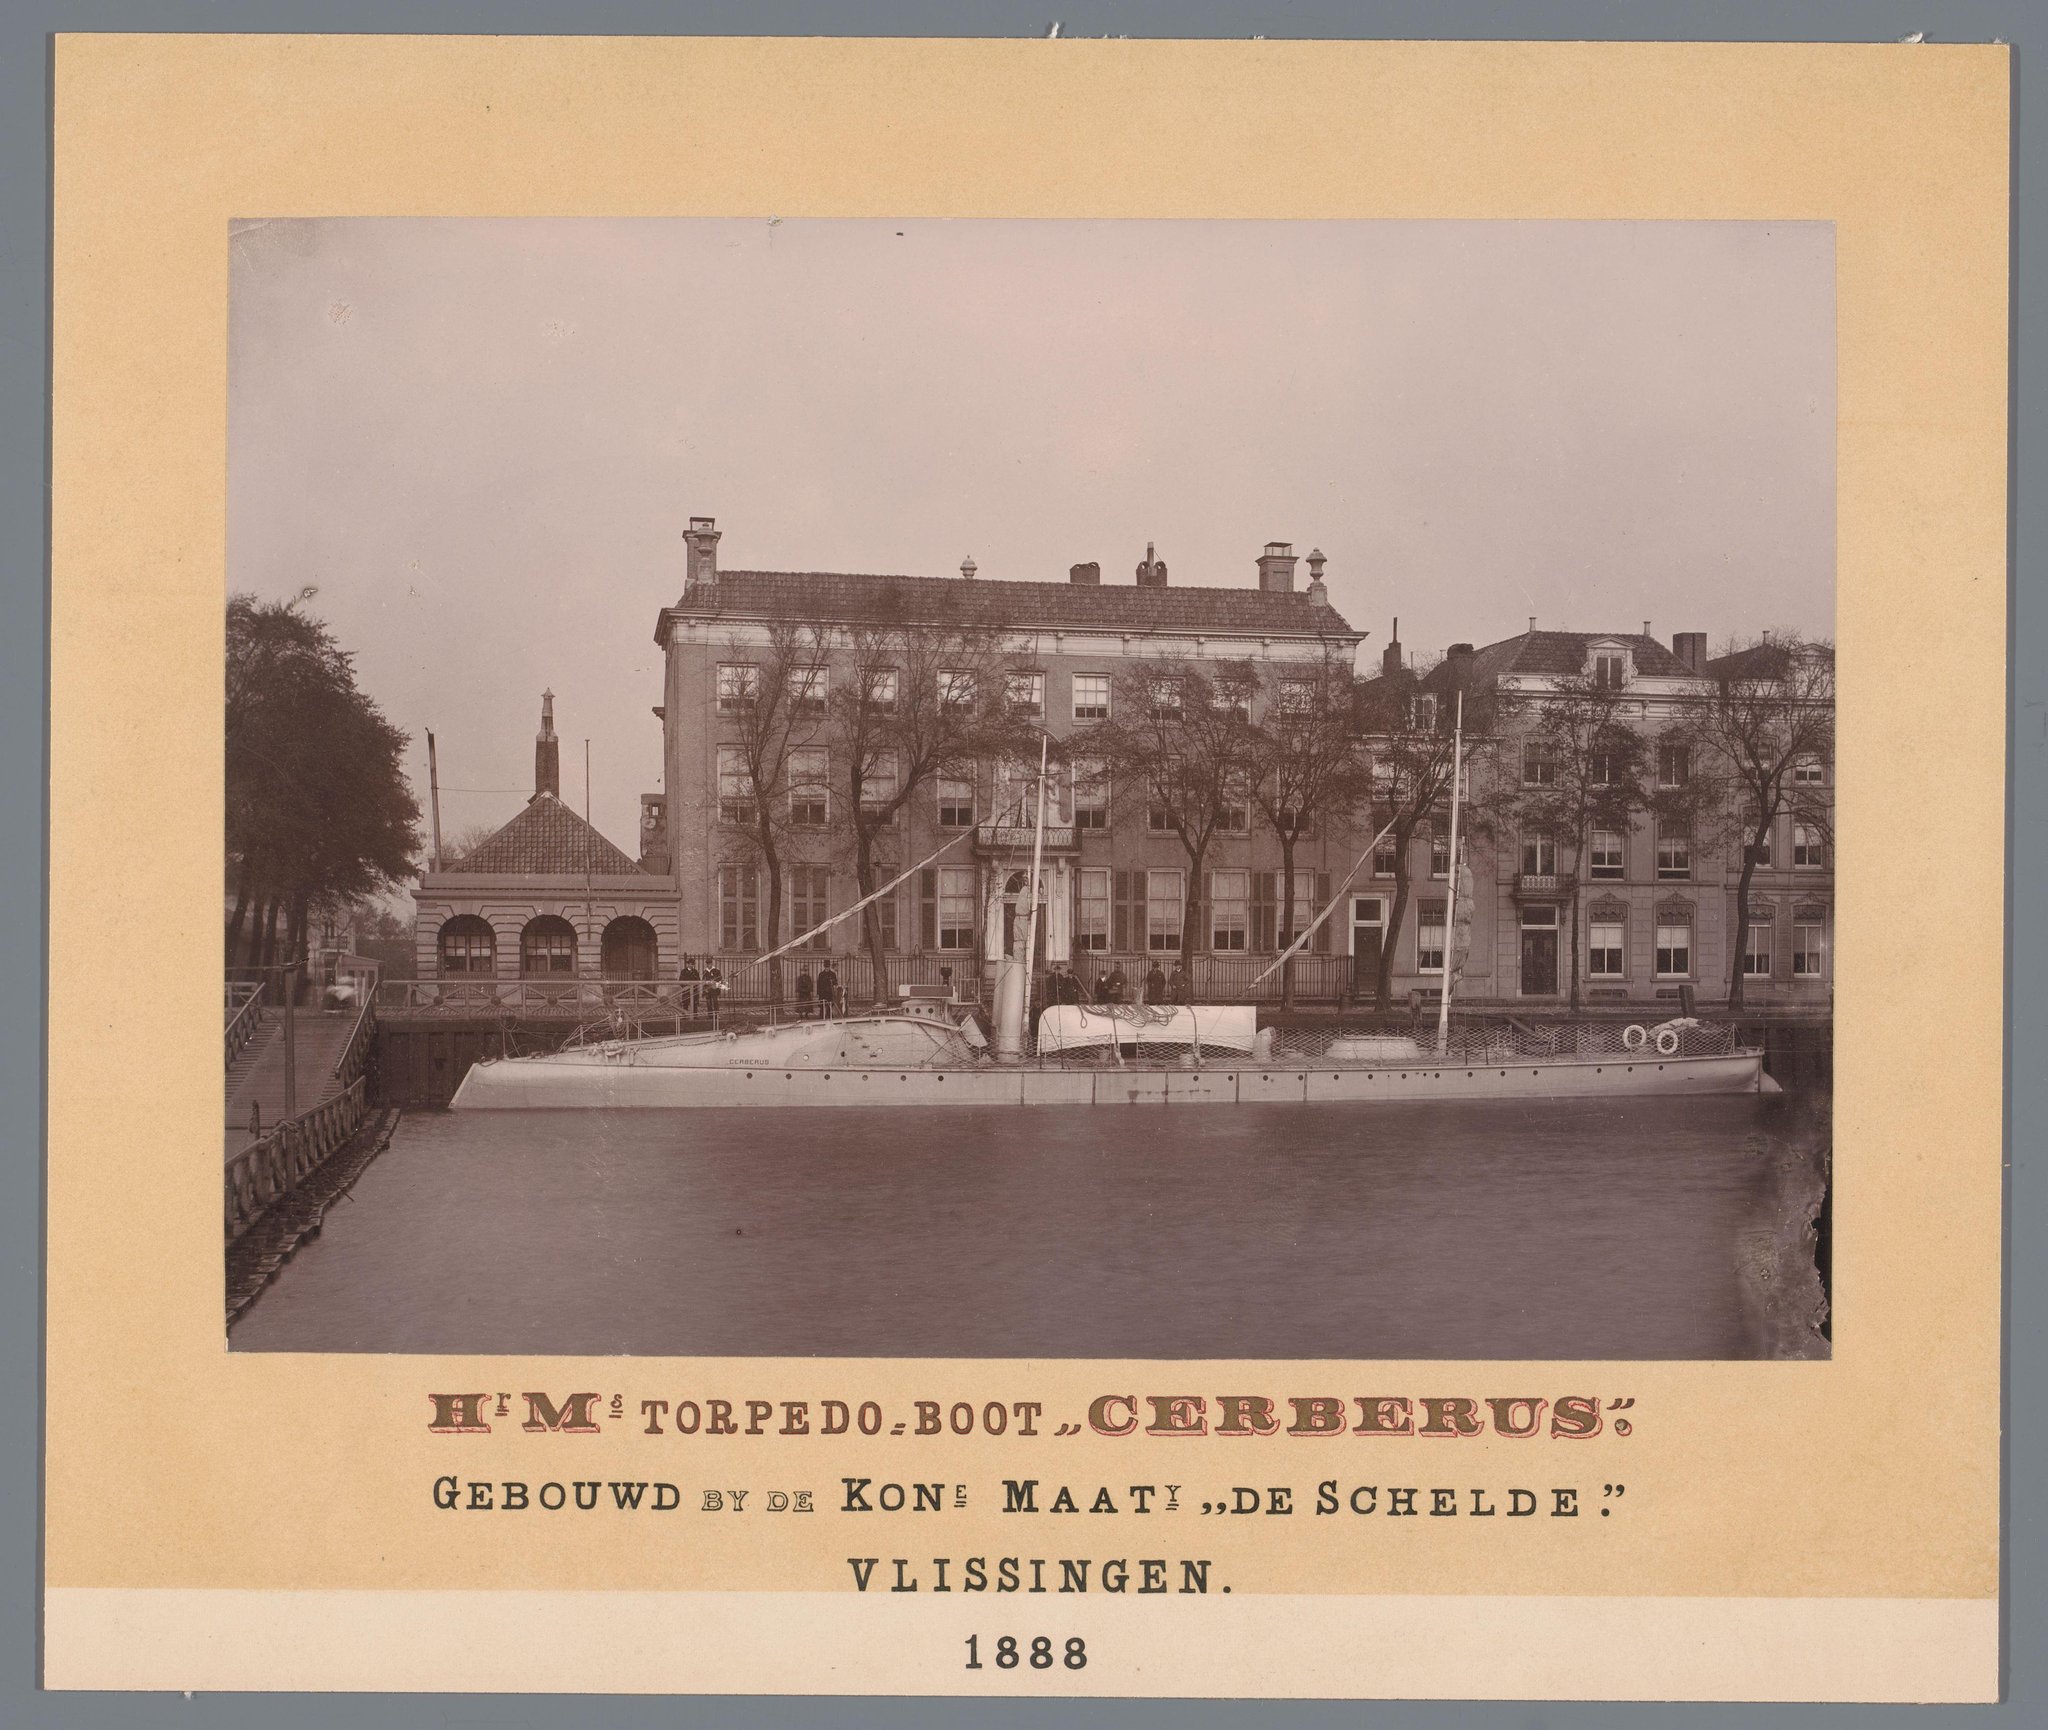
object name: photograph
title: Triple Compound Machine van HrMs Torpedoboot Cerberus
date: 1888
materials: cardboard, paper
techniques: photography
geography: flushing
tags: flushing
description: Foto van een stoomschip, met onderschrift, naam van de machine in rood/geel, rest in zwart. Opschrift; o.: 'Vervaardigd door de Koninklijke Maatschapij "De Schelde".